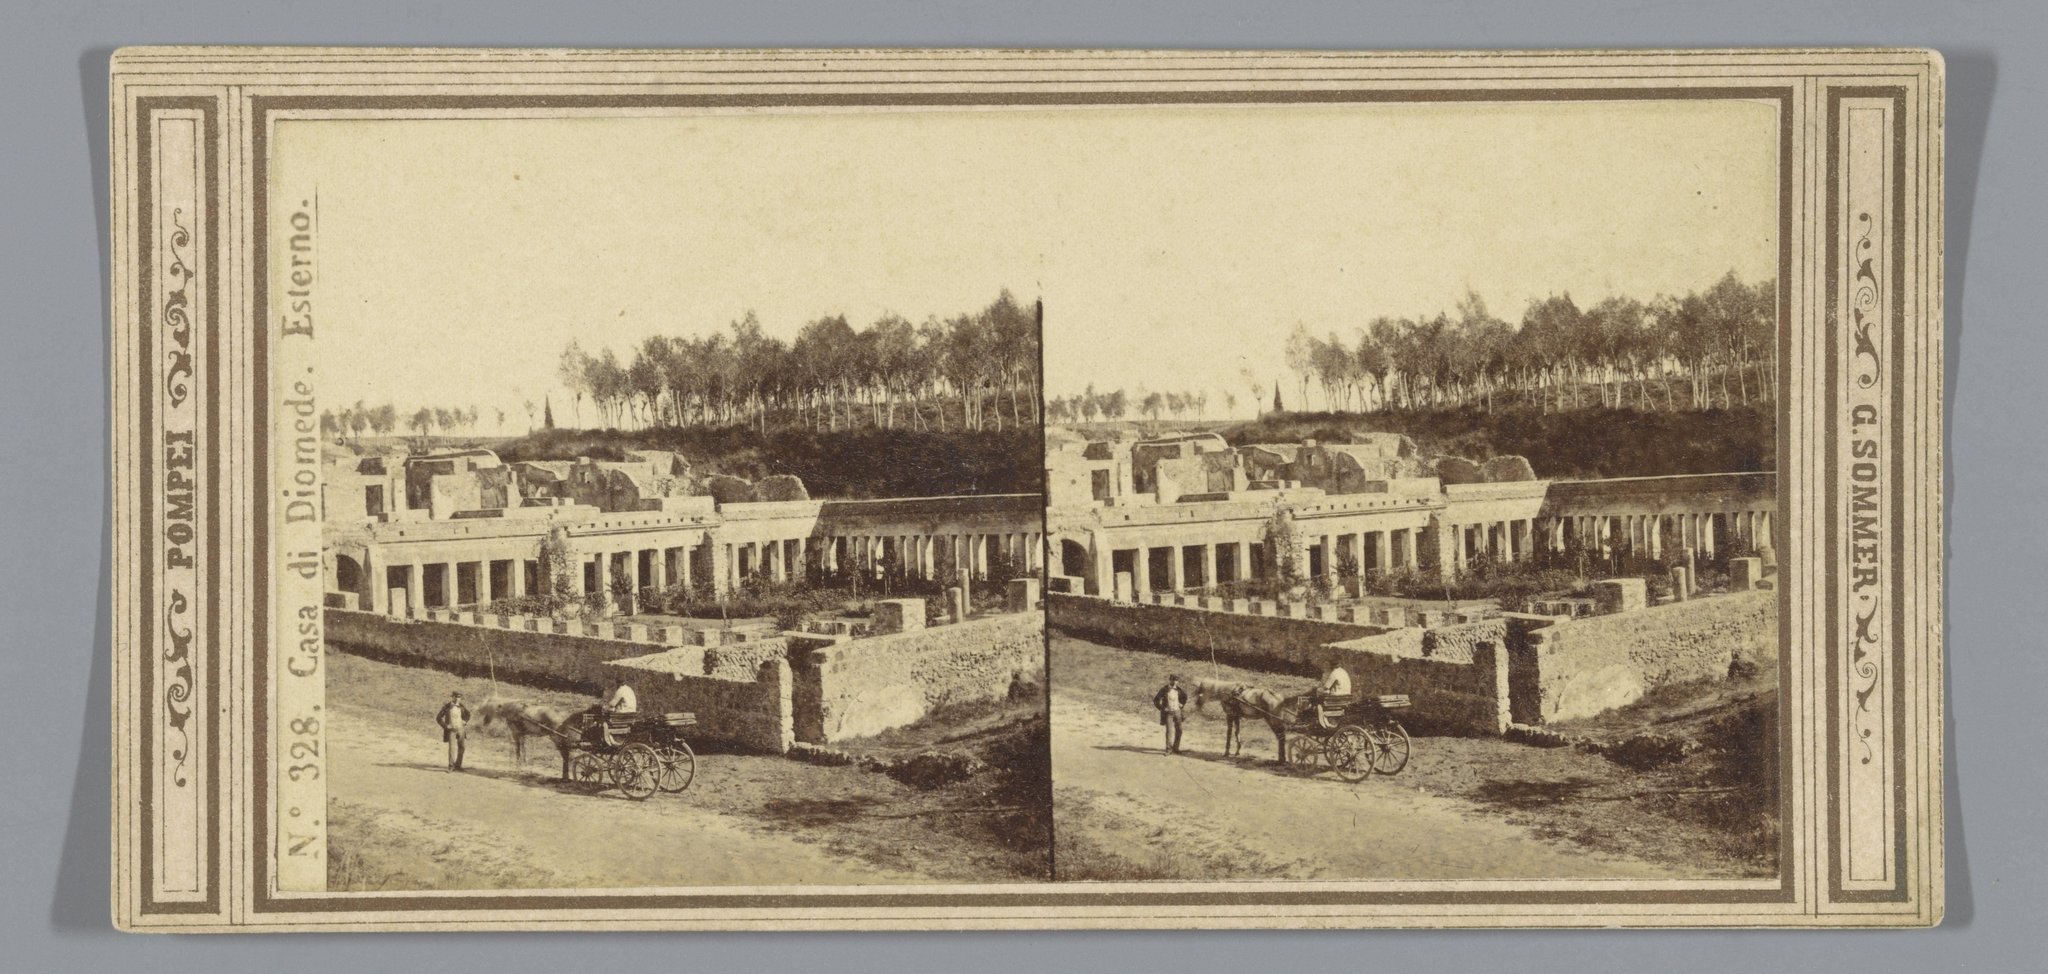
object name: stereograph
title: Pompei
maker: giorgio sommer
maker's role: fotograaf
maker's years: 1834-1914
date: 1860-1880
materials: cardboard, photographic support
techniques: albumen print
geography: pompeii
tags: ruin of a dwelling, house, castle, etc., pompeii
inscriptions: number: ‘No. 328.’, number: ‘L 1.’